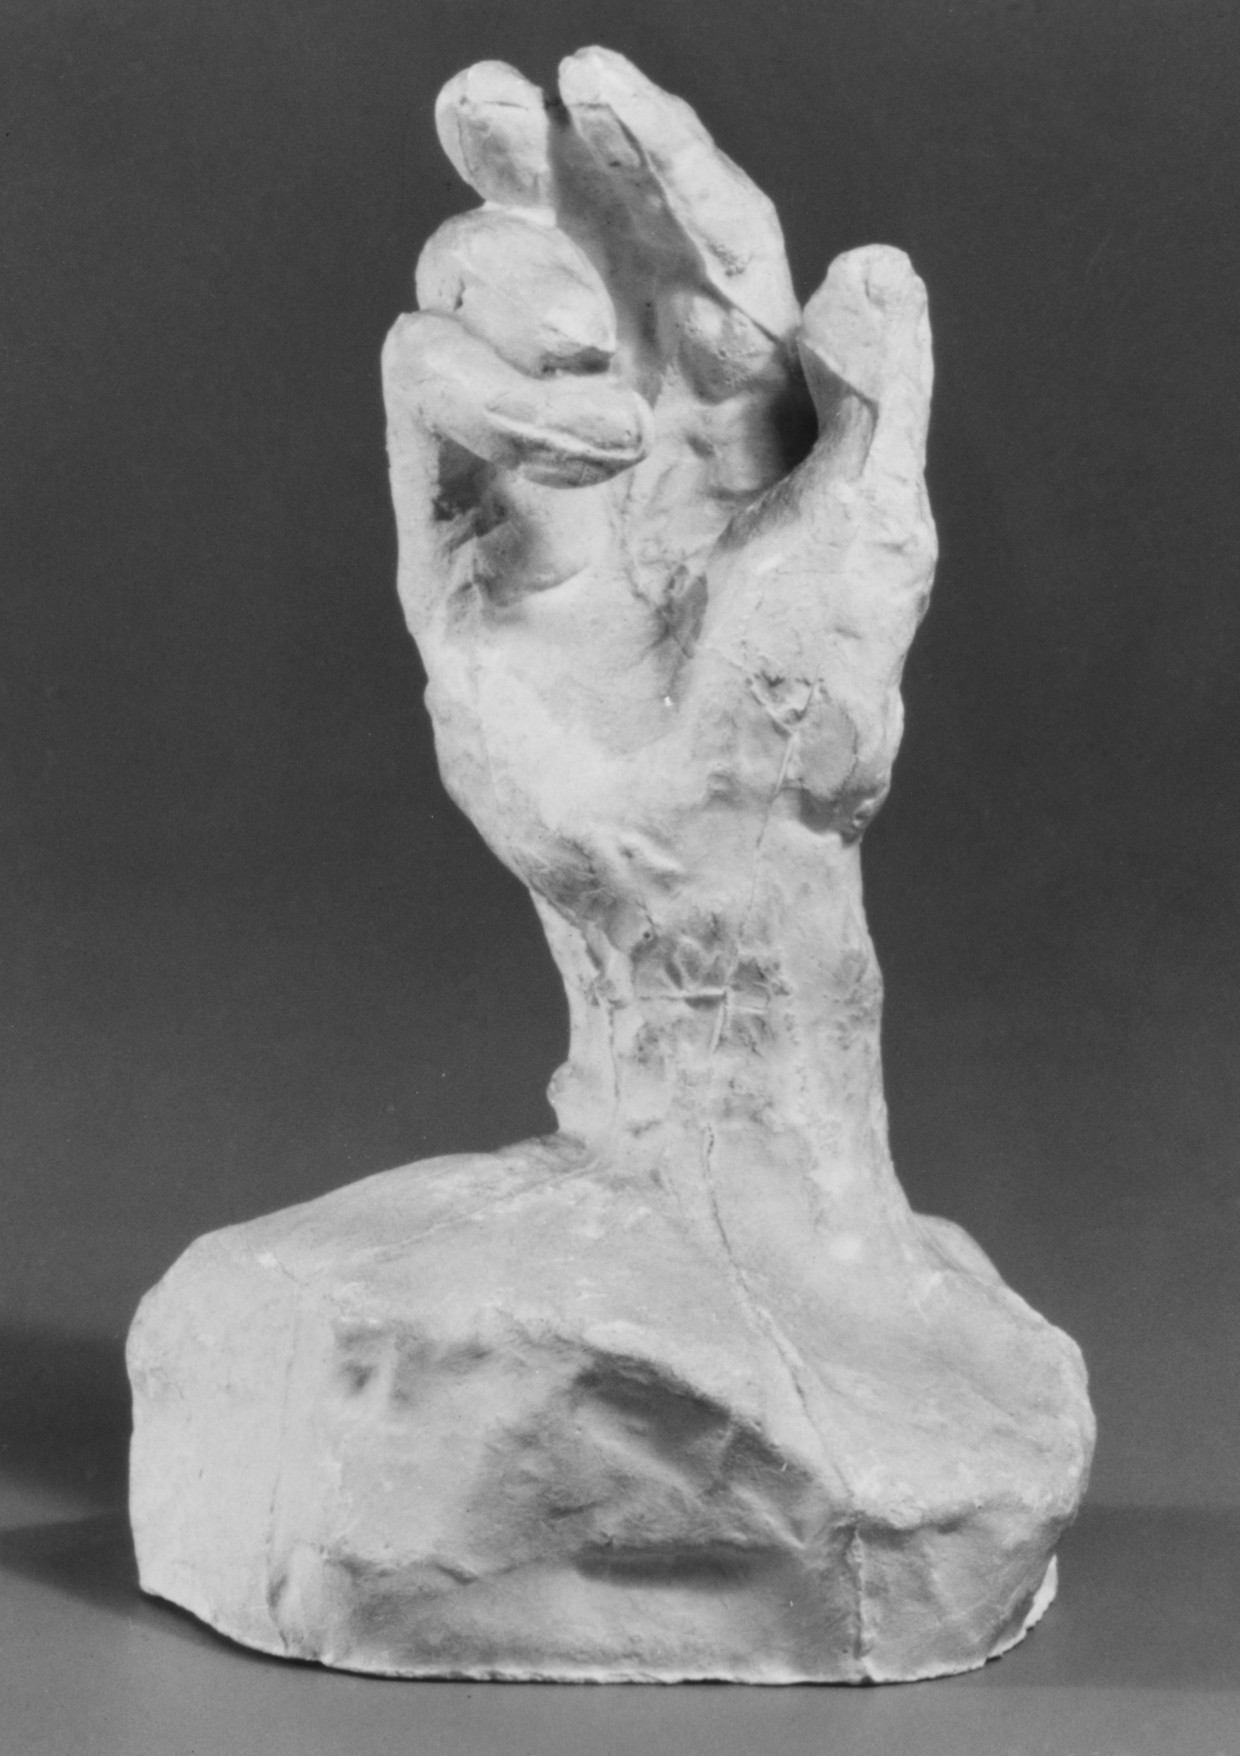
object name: cast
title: Hand with base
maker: auguste rodin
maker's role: artist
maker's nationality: french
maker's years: 1840-1917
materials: plaster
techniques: casting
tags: hands